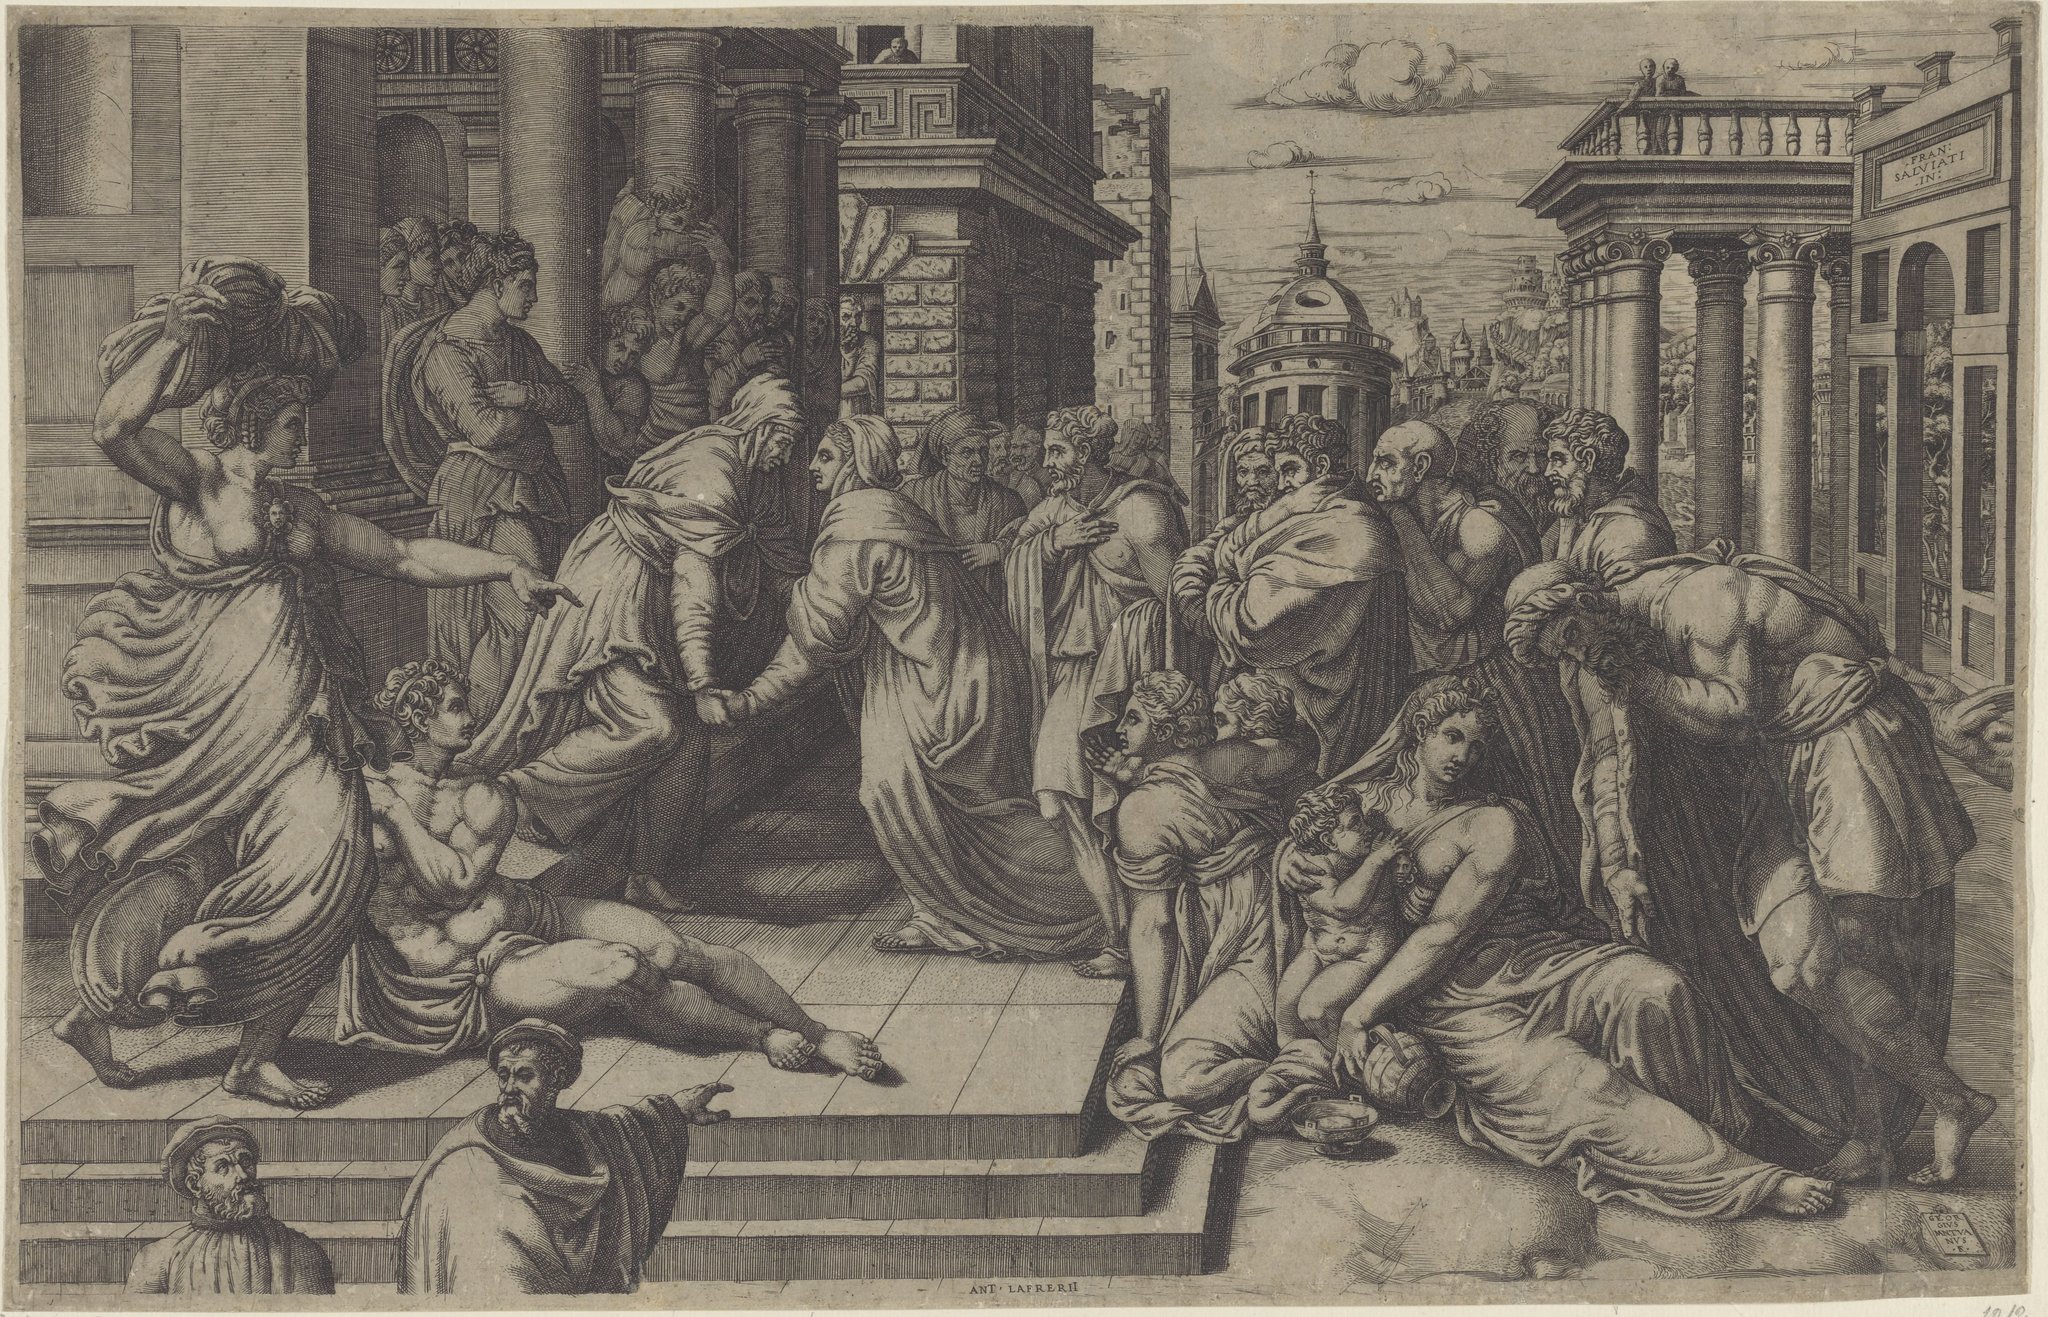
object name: print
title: Visitatie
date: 1530-1582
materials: paper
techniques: engraving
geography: italy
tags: visitation (possibly joseph and/or zacharias present) (luke 1:39-56)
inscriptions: collector's mark: Lugt 240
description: Maria en Elisabet, beiden zwanger, ontmoeten elkaar op een trap. Verschillende mannen, vrouwen en kinderen kijken naar de ontmoeting.